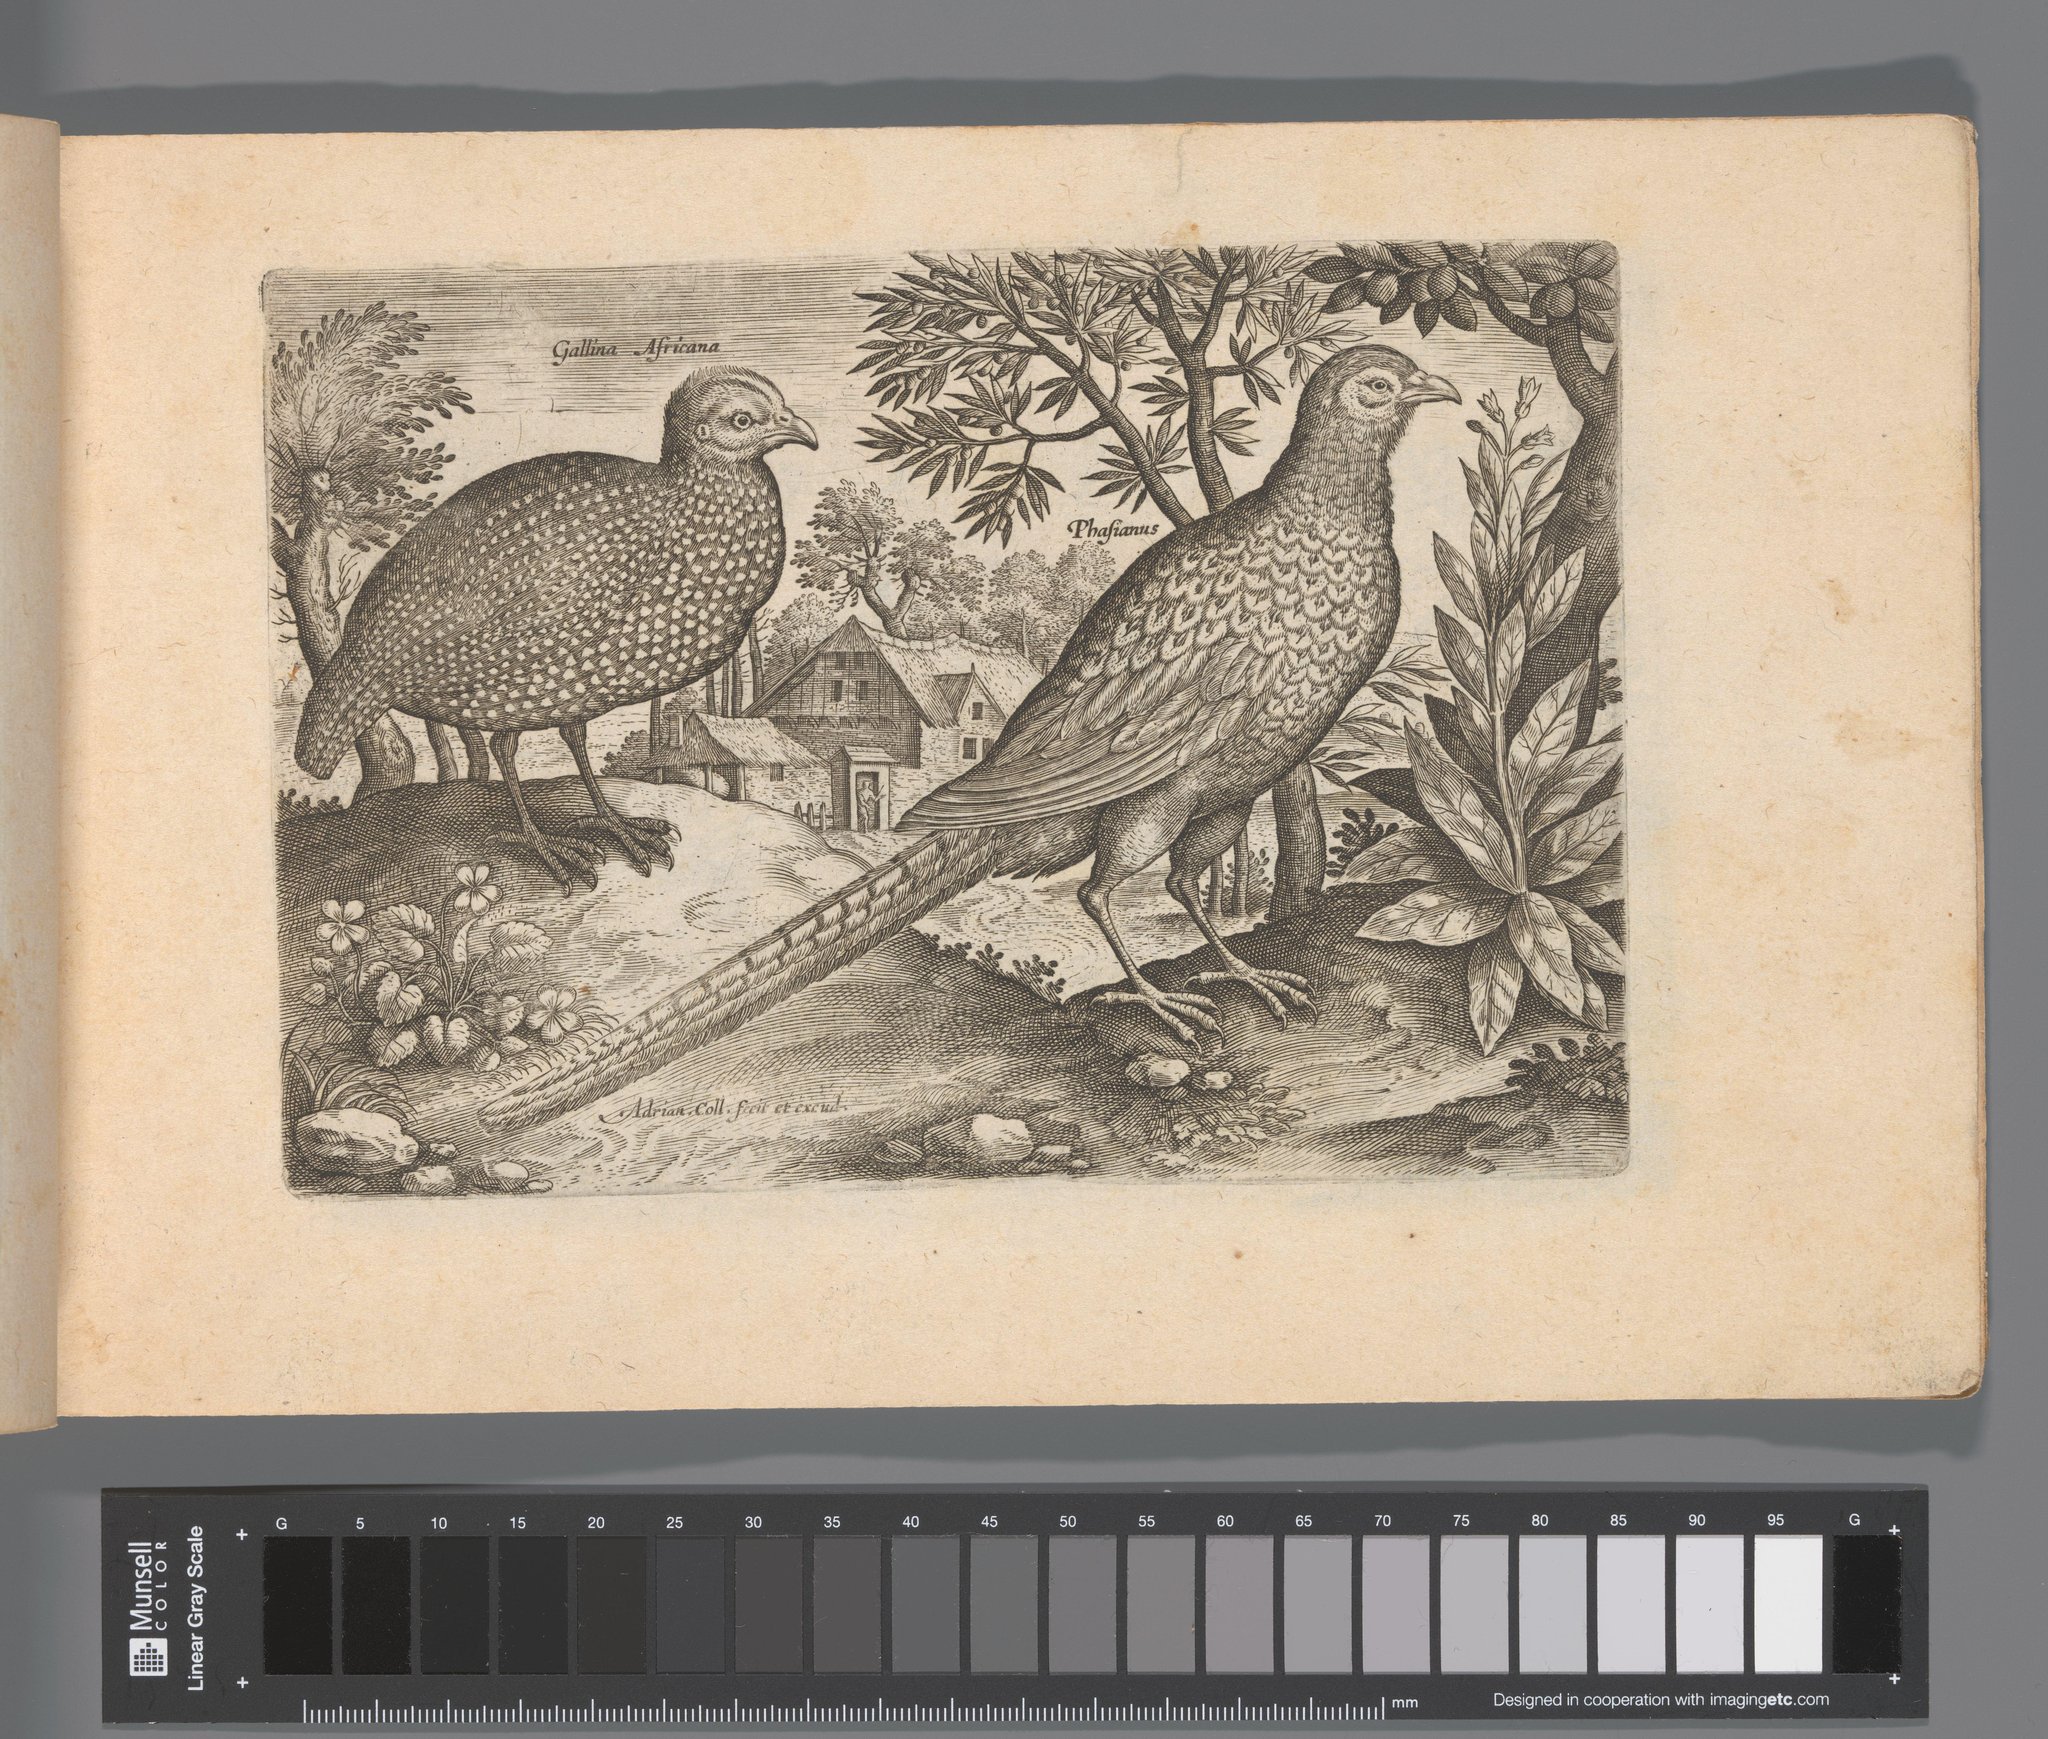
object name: album leaf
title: Twee hoenders in een landschap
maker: adriaen collaert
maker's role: draughtsman, print maker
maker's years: 1560-1618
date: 1570-1600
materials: paper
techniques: engraving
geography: antwerp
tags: walker and runner birds: pheasant, walker and runner birds: guineafowl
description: Een parelhoen en een fazant in een landschap met een boerderij. Prent is onderdeel van een prentalbum met zeven prenten van vogels en de titelprent.